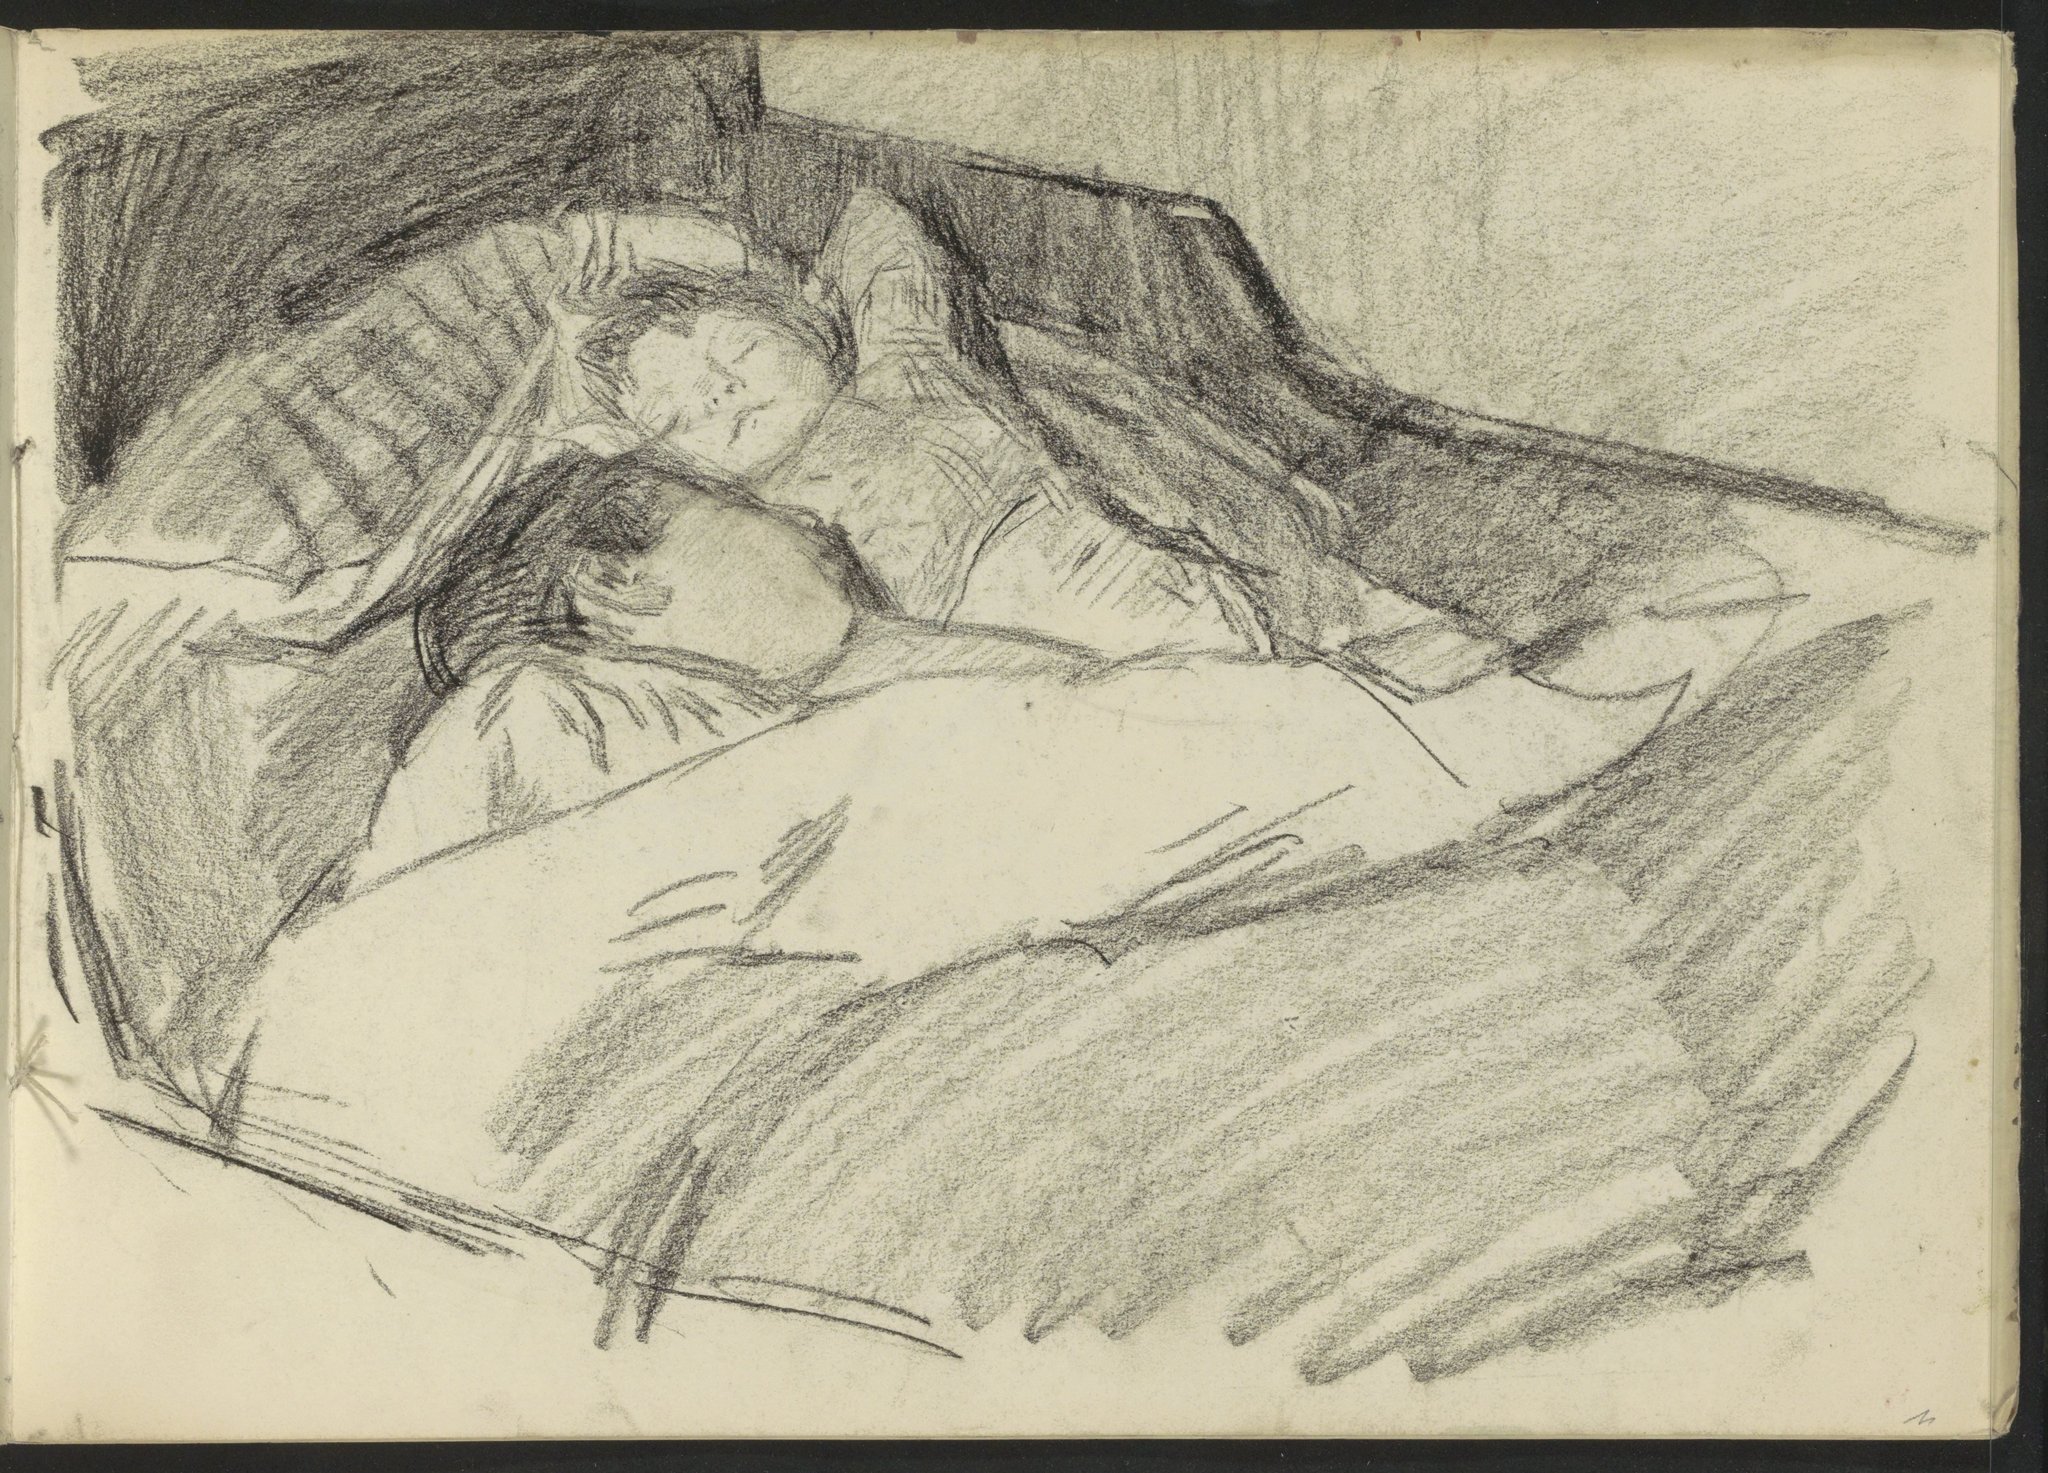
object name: sketchbook leaf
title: Twee slapende kinderen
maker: isaac israels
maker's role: draughtsman, painter, print maker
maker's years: 1865-1934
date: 1875-1934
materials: chalk, paper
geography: the hague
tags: sleeping in bed, child (+ two persons)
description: In een bed of wieg. Blad 11 recto uit schetsboek XII met 19 bladen.